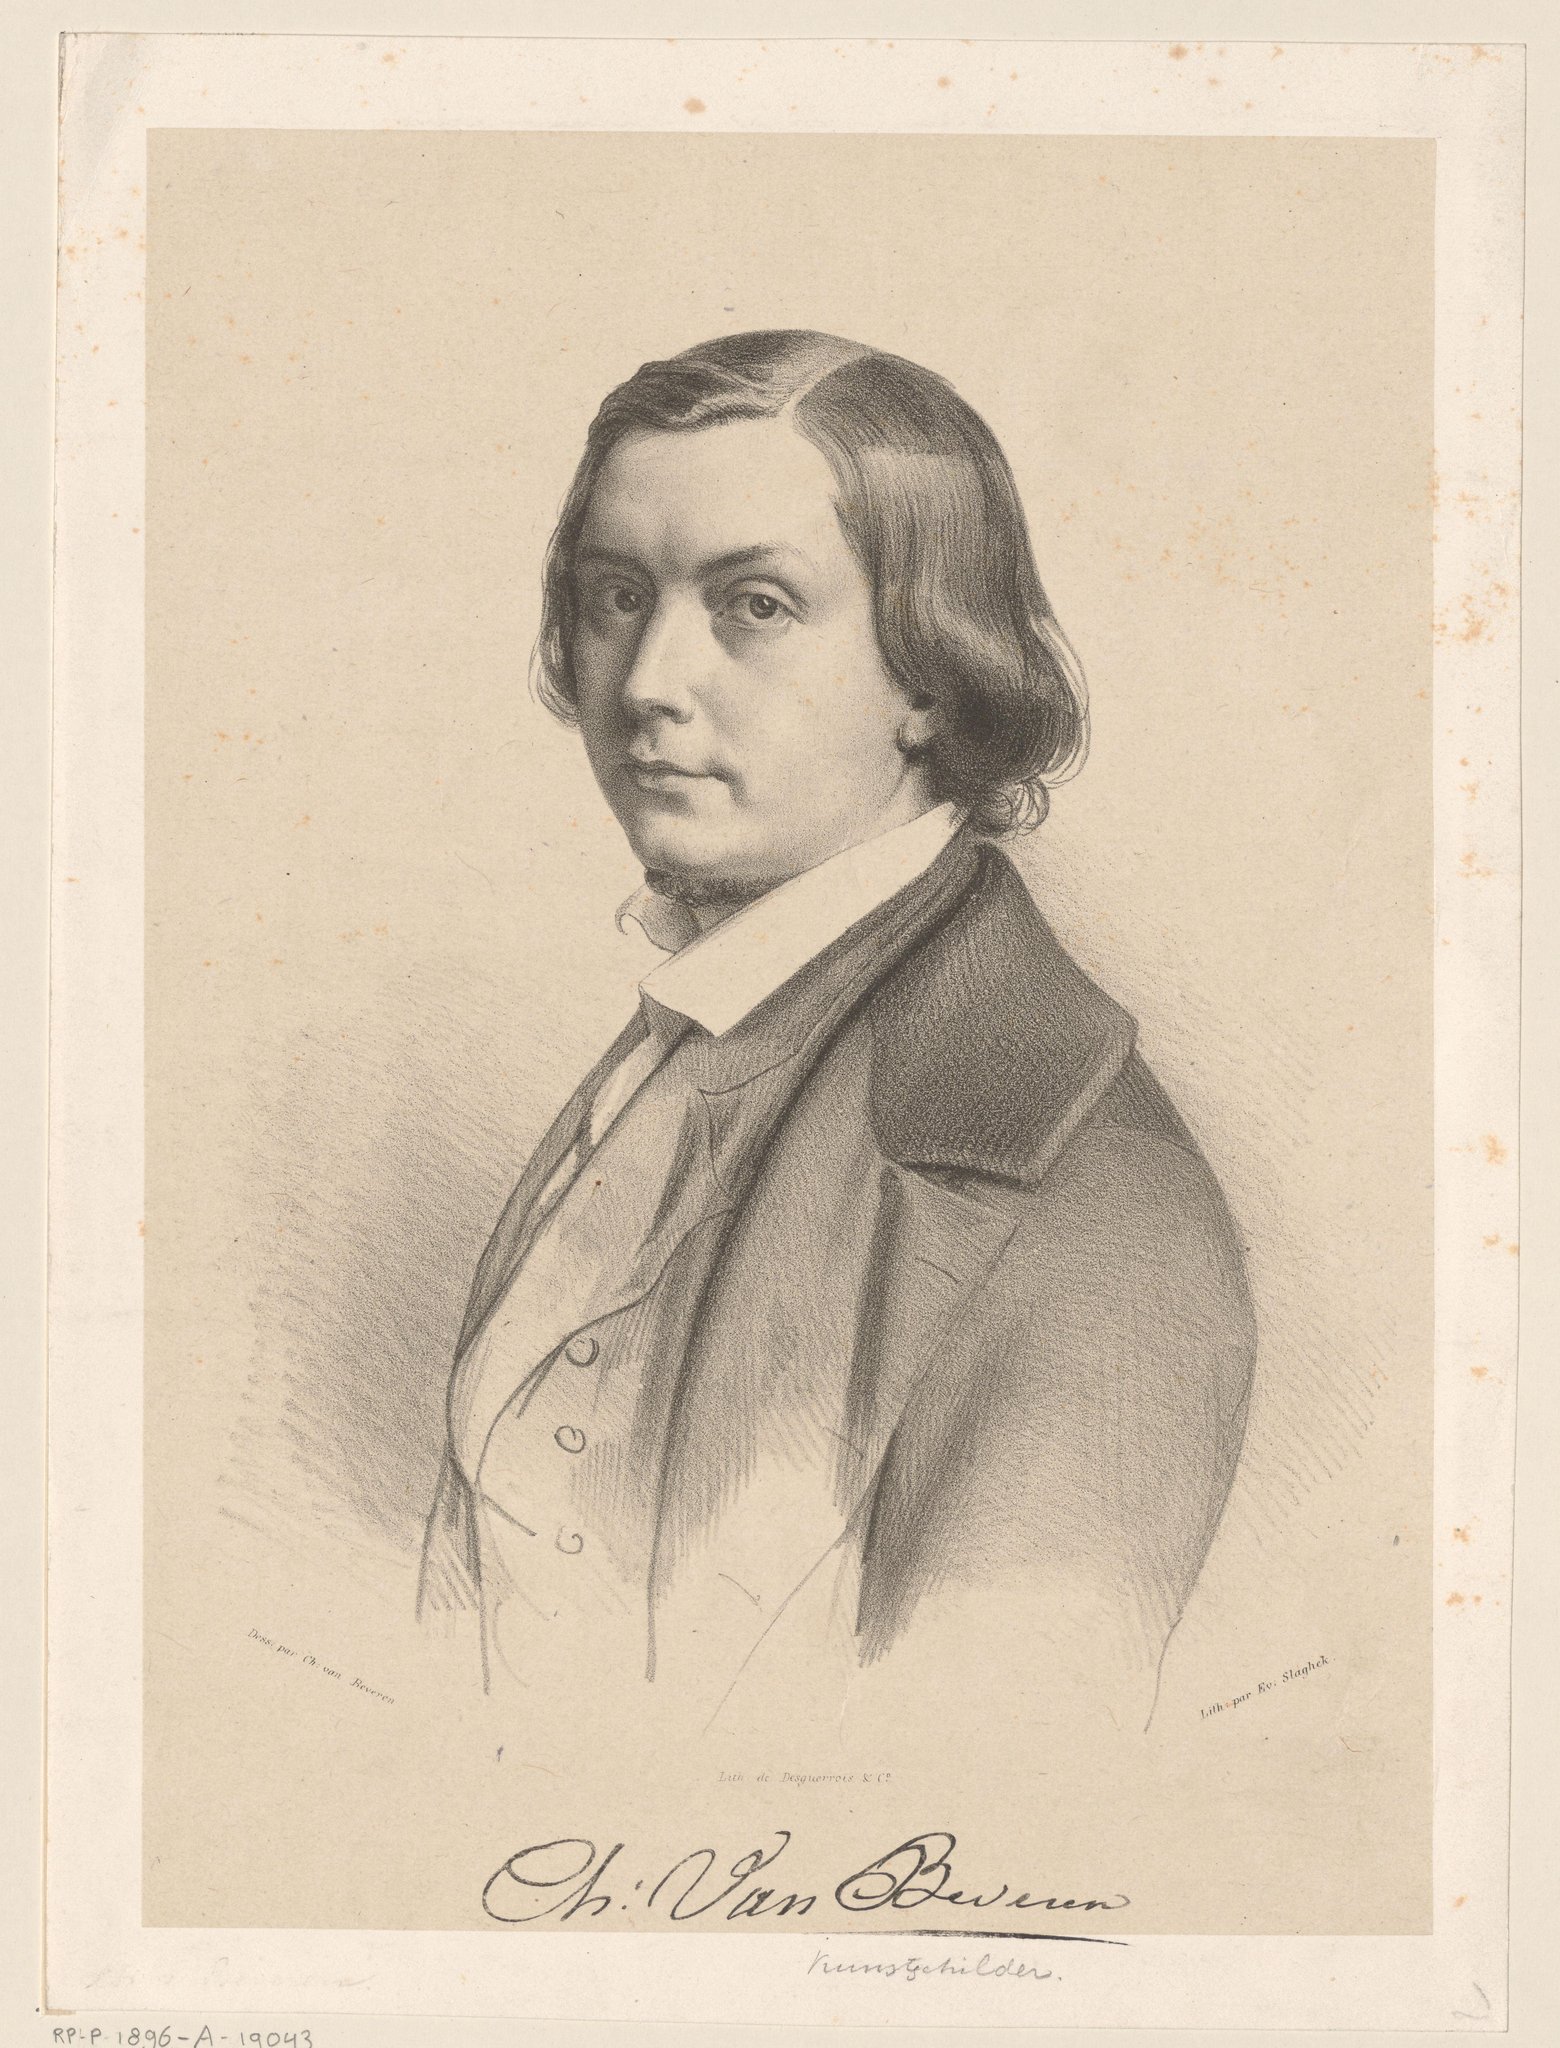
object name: print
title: Portret van Charles van Beveren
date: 1837-1896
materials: paper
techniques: lithograph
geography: amsterdam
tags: mechelen, charles van beveren, historical persons, portrait, self-portrait of painter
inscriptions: collector's mark: Lugt 2228